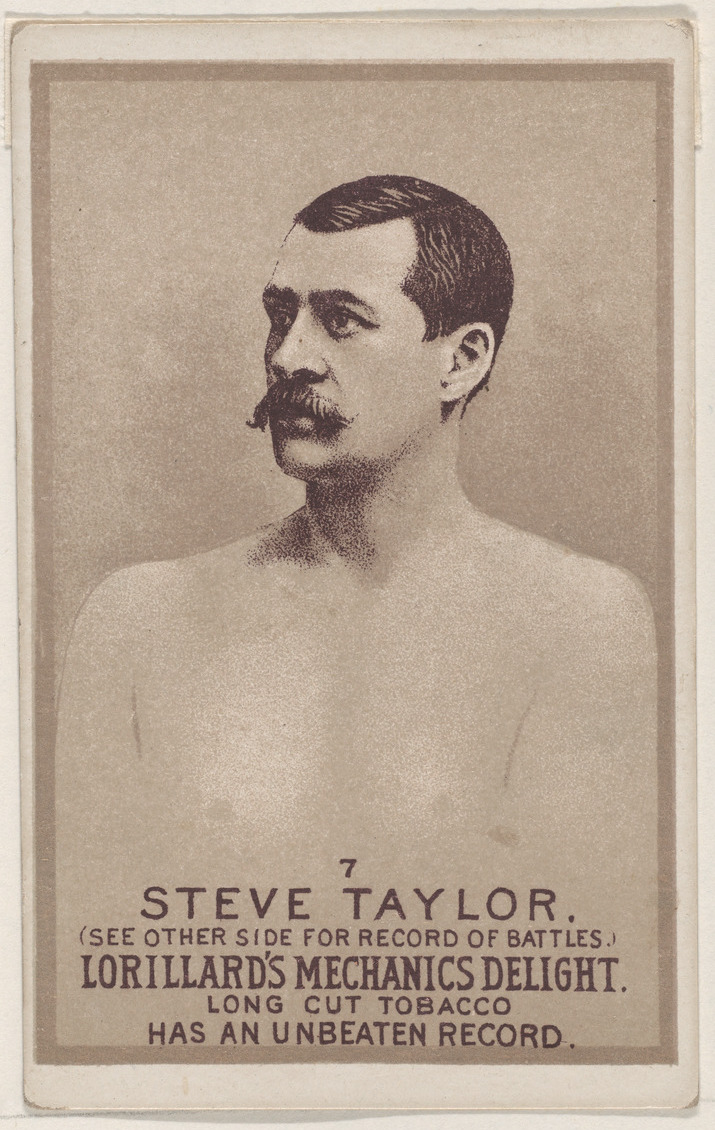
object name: print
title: Card 7, Steve Taylor, from the Prizefighters series (N269) issued by P. Lorillard Company to promote Mechanics Delight Long Cut Tobacco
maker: p. lorillard company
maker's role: publisher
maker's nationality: american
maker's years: 1760-2014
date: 1887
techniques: color lithograph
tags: men,portraits,boxing,athletes